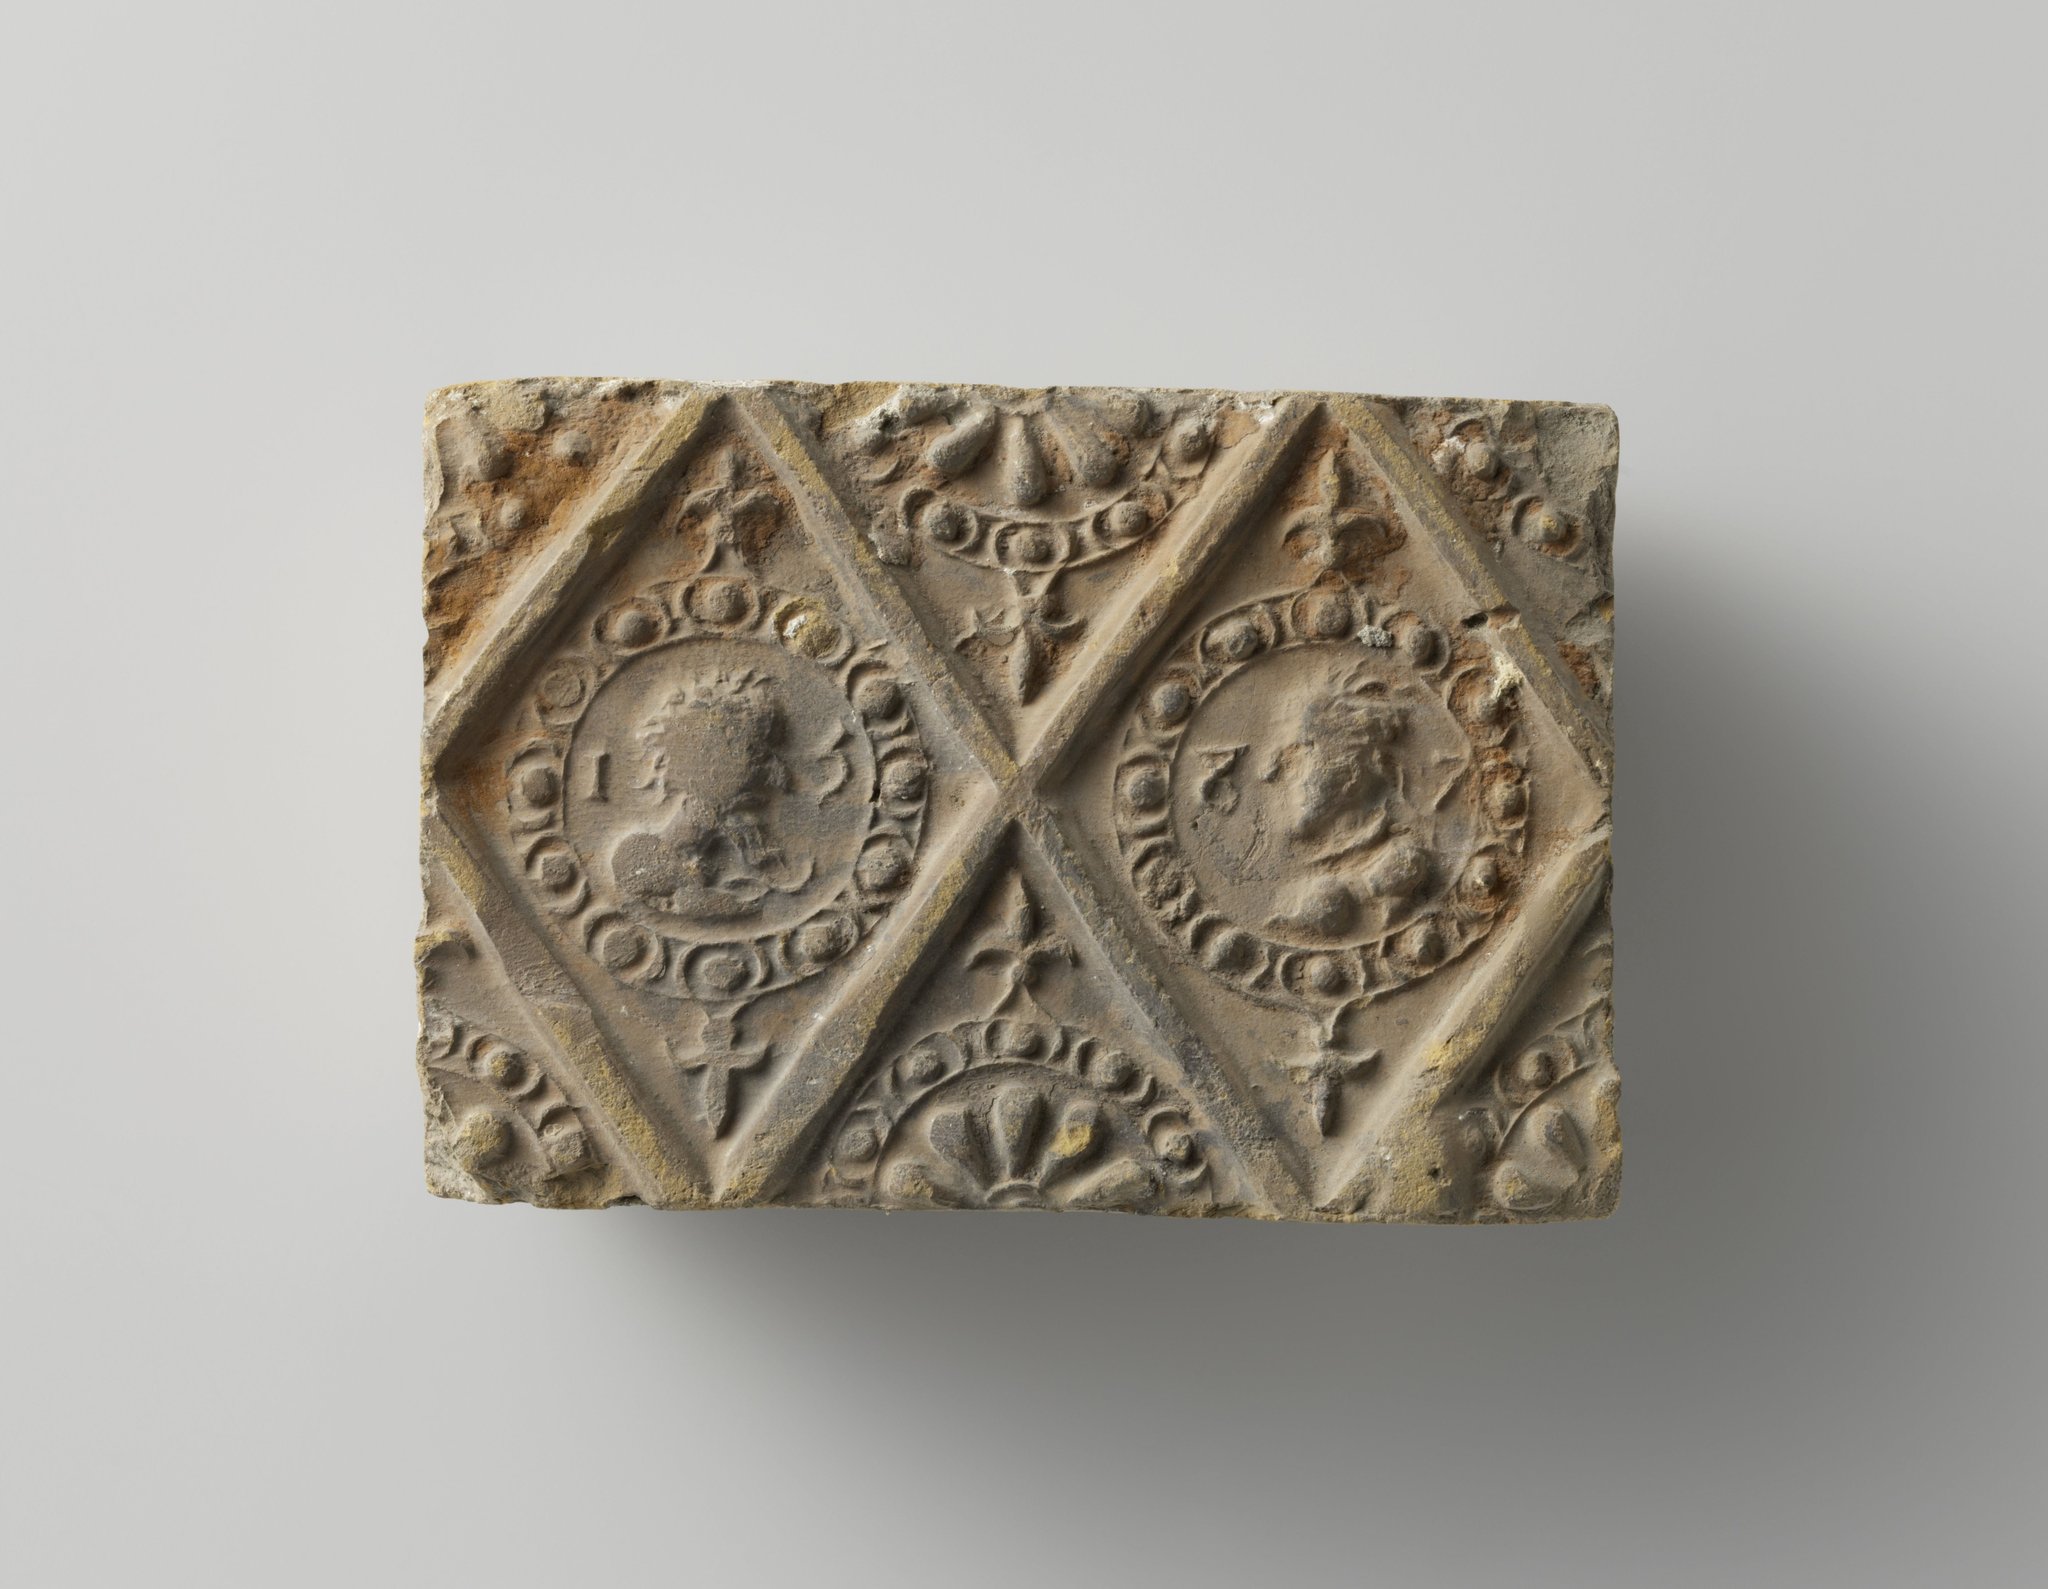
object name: sculpture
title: Haardsteen met afbeelding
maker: Anonymous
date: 1587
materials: earthenware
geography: southern netherlands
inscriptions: date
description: Haardsteen met een afbeelding van twee vorstelijke busten; een man en een vrouw en het jaartal 1587.